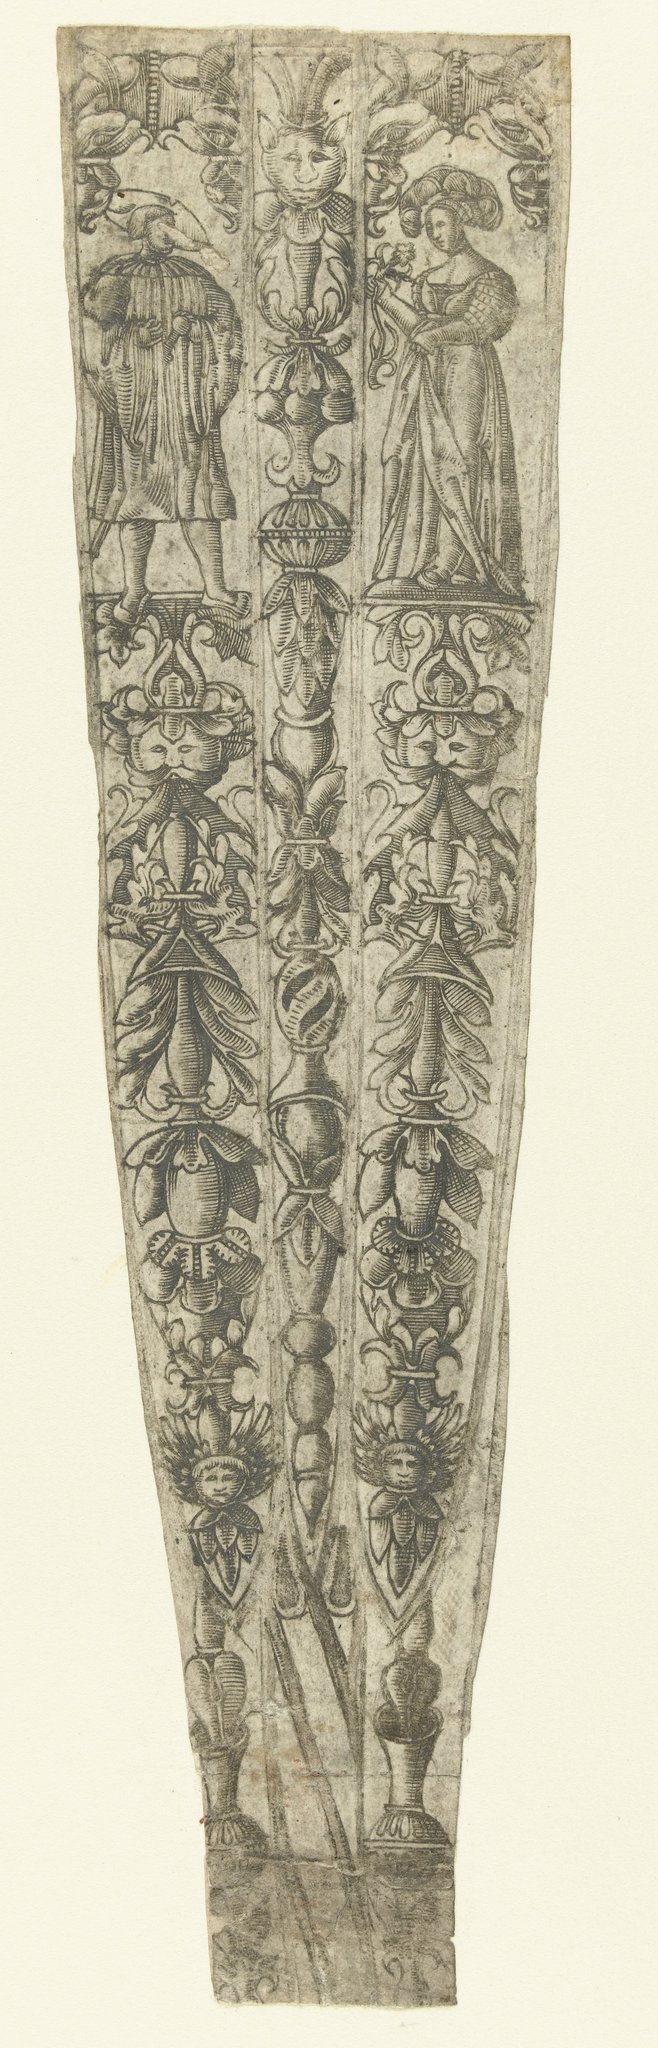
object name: print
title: Schede waarvan beide zijden worden getoond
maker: Anonymous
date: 1500-1600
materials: paper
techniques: engraving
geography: germany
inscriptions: collector's mark: Lugt 240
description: Beide zijden van de schede zijn gedecoreerd met kandelabers waarop links een man staat en rechts een vrouw met een bloem in haar hand. In het midden loopt een band met een kandelaber, bedoeld ter decoratie van de zijkant van de schede.